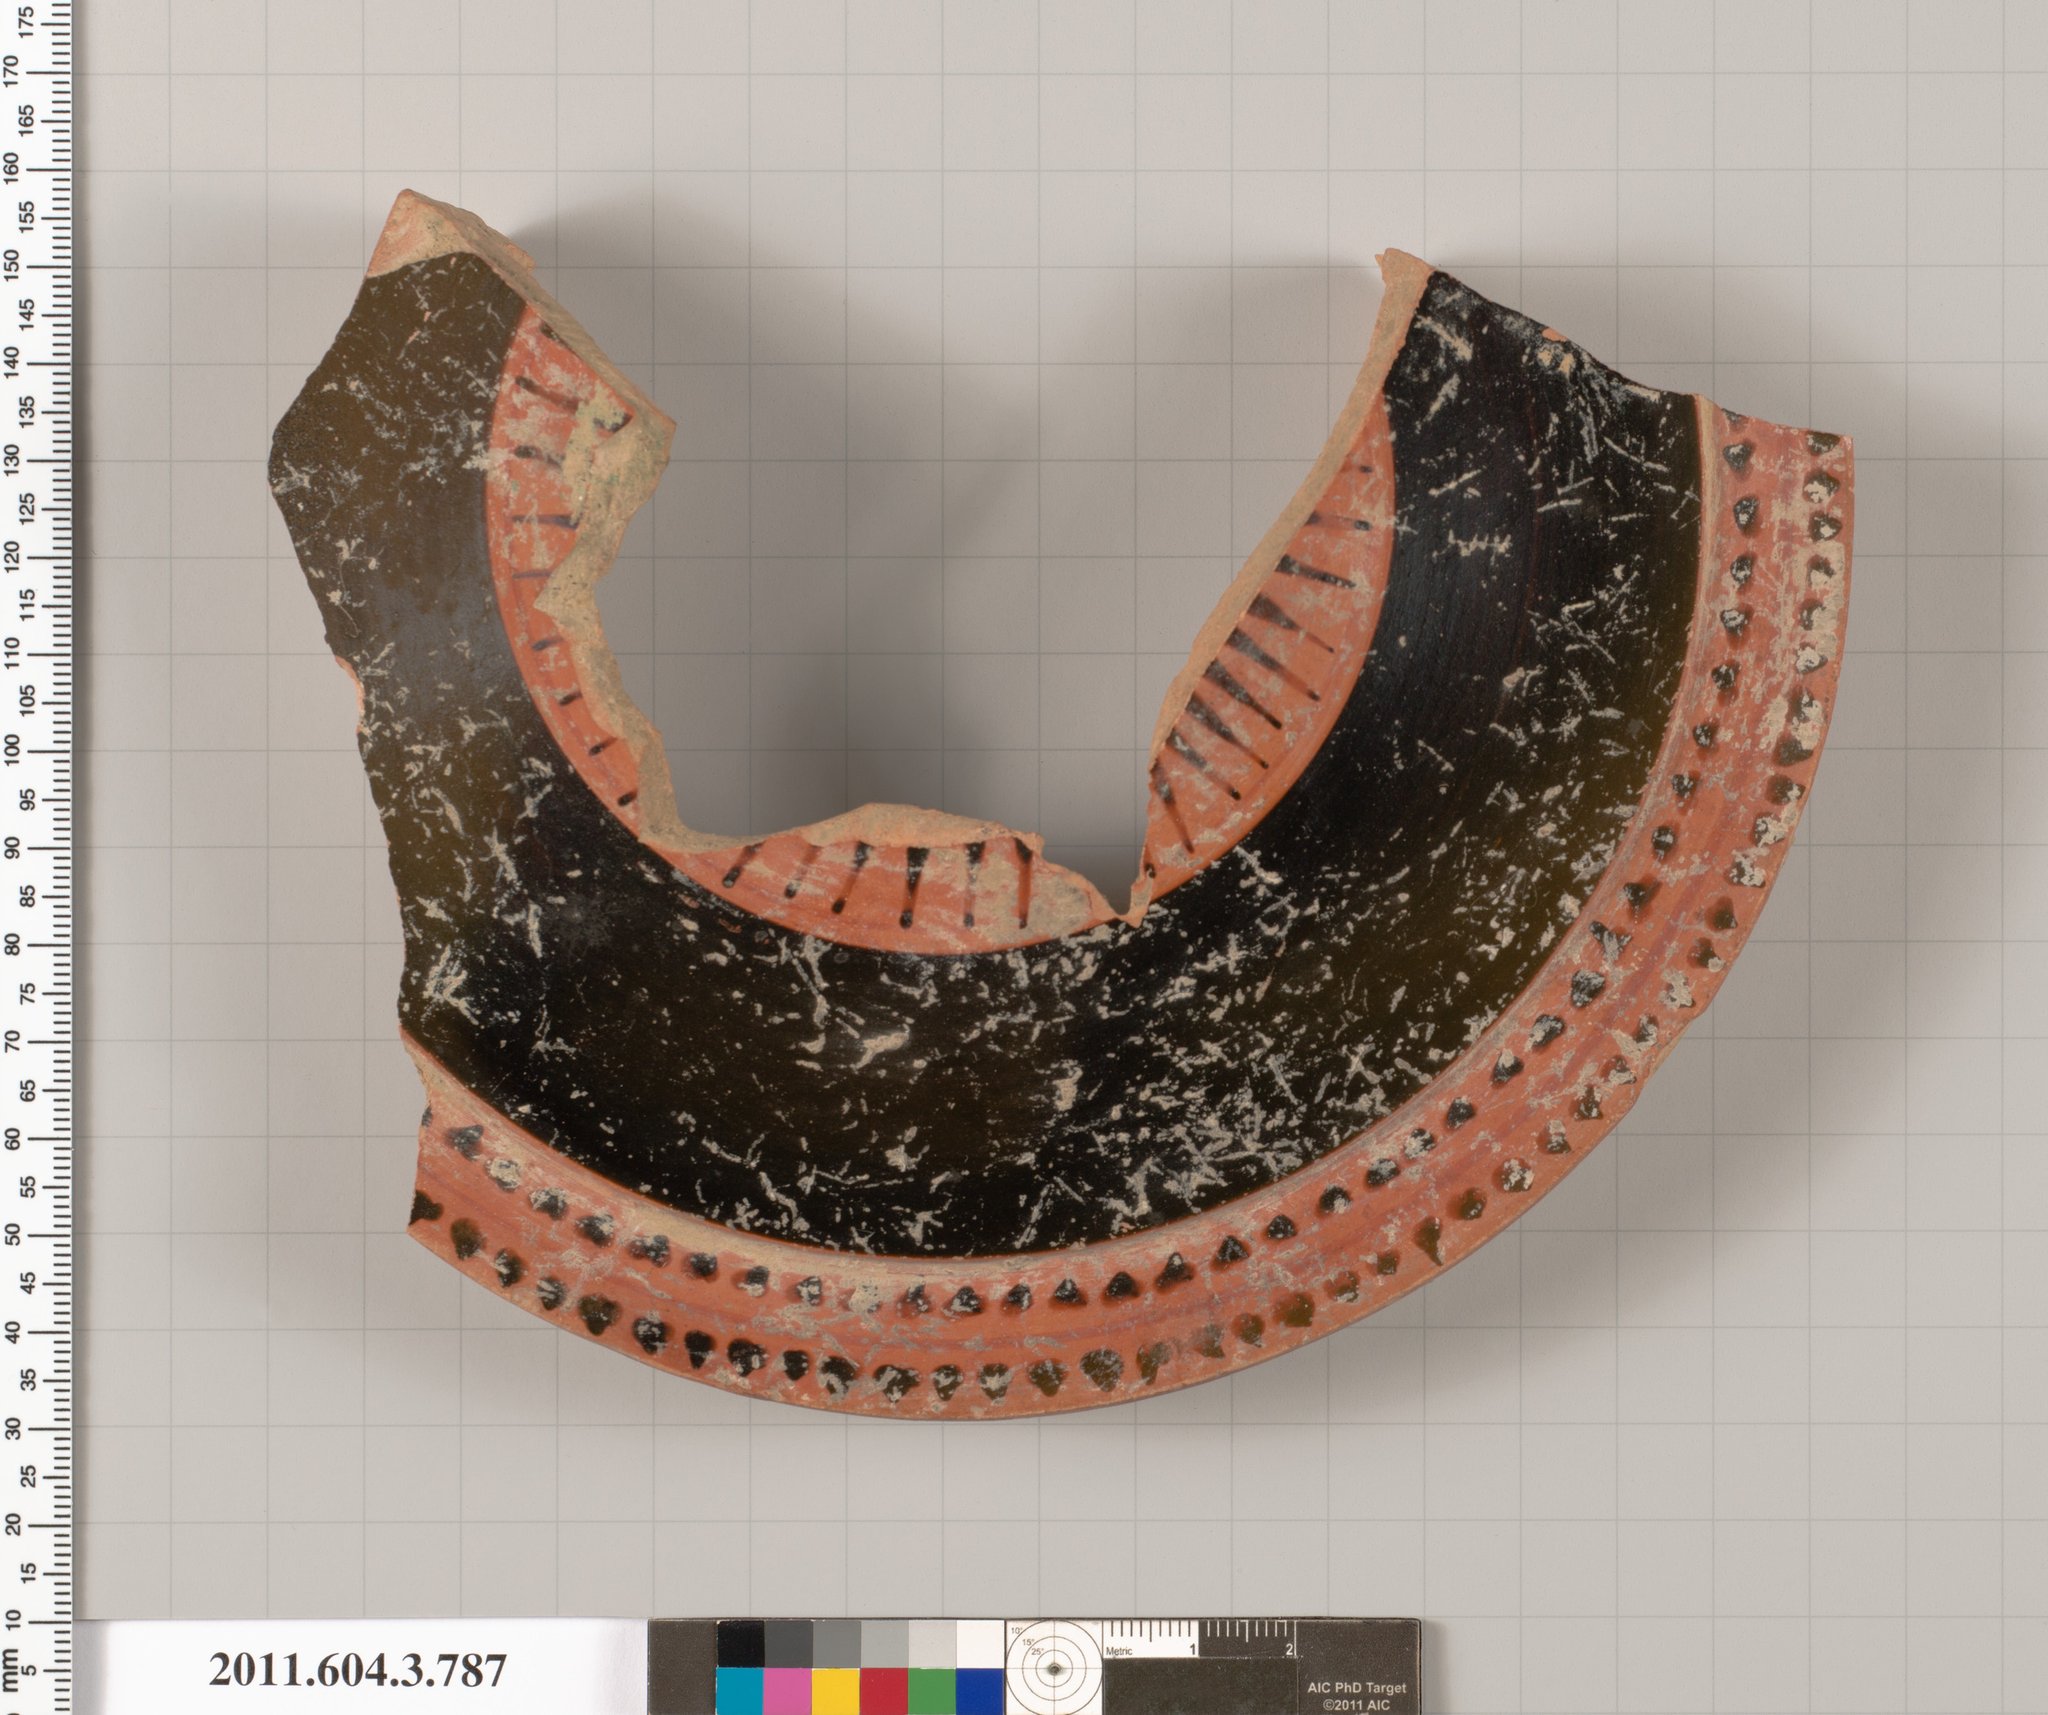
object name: lid fragment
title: Terracotta fragment of a lid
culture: greek, attic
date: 600-501 BCE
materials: terracotta